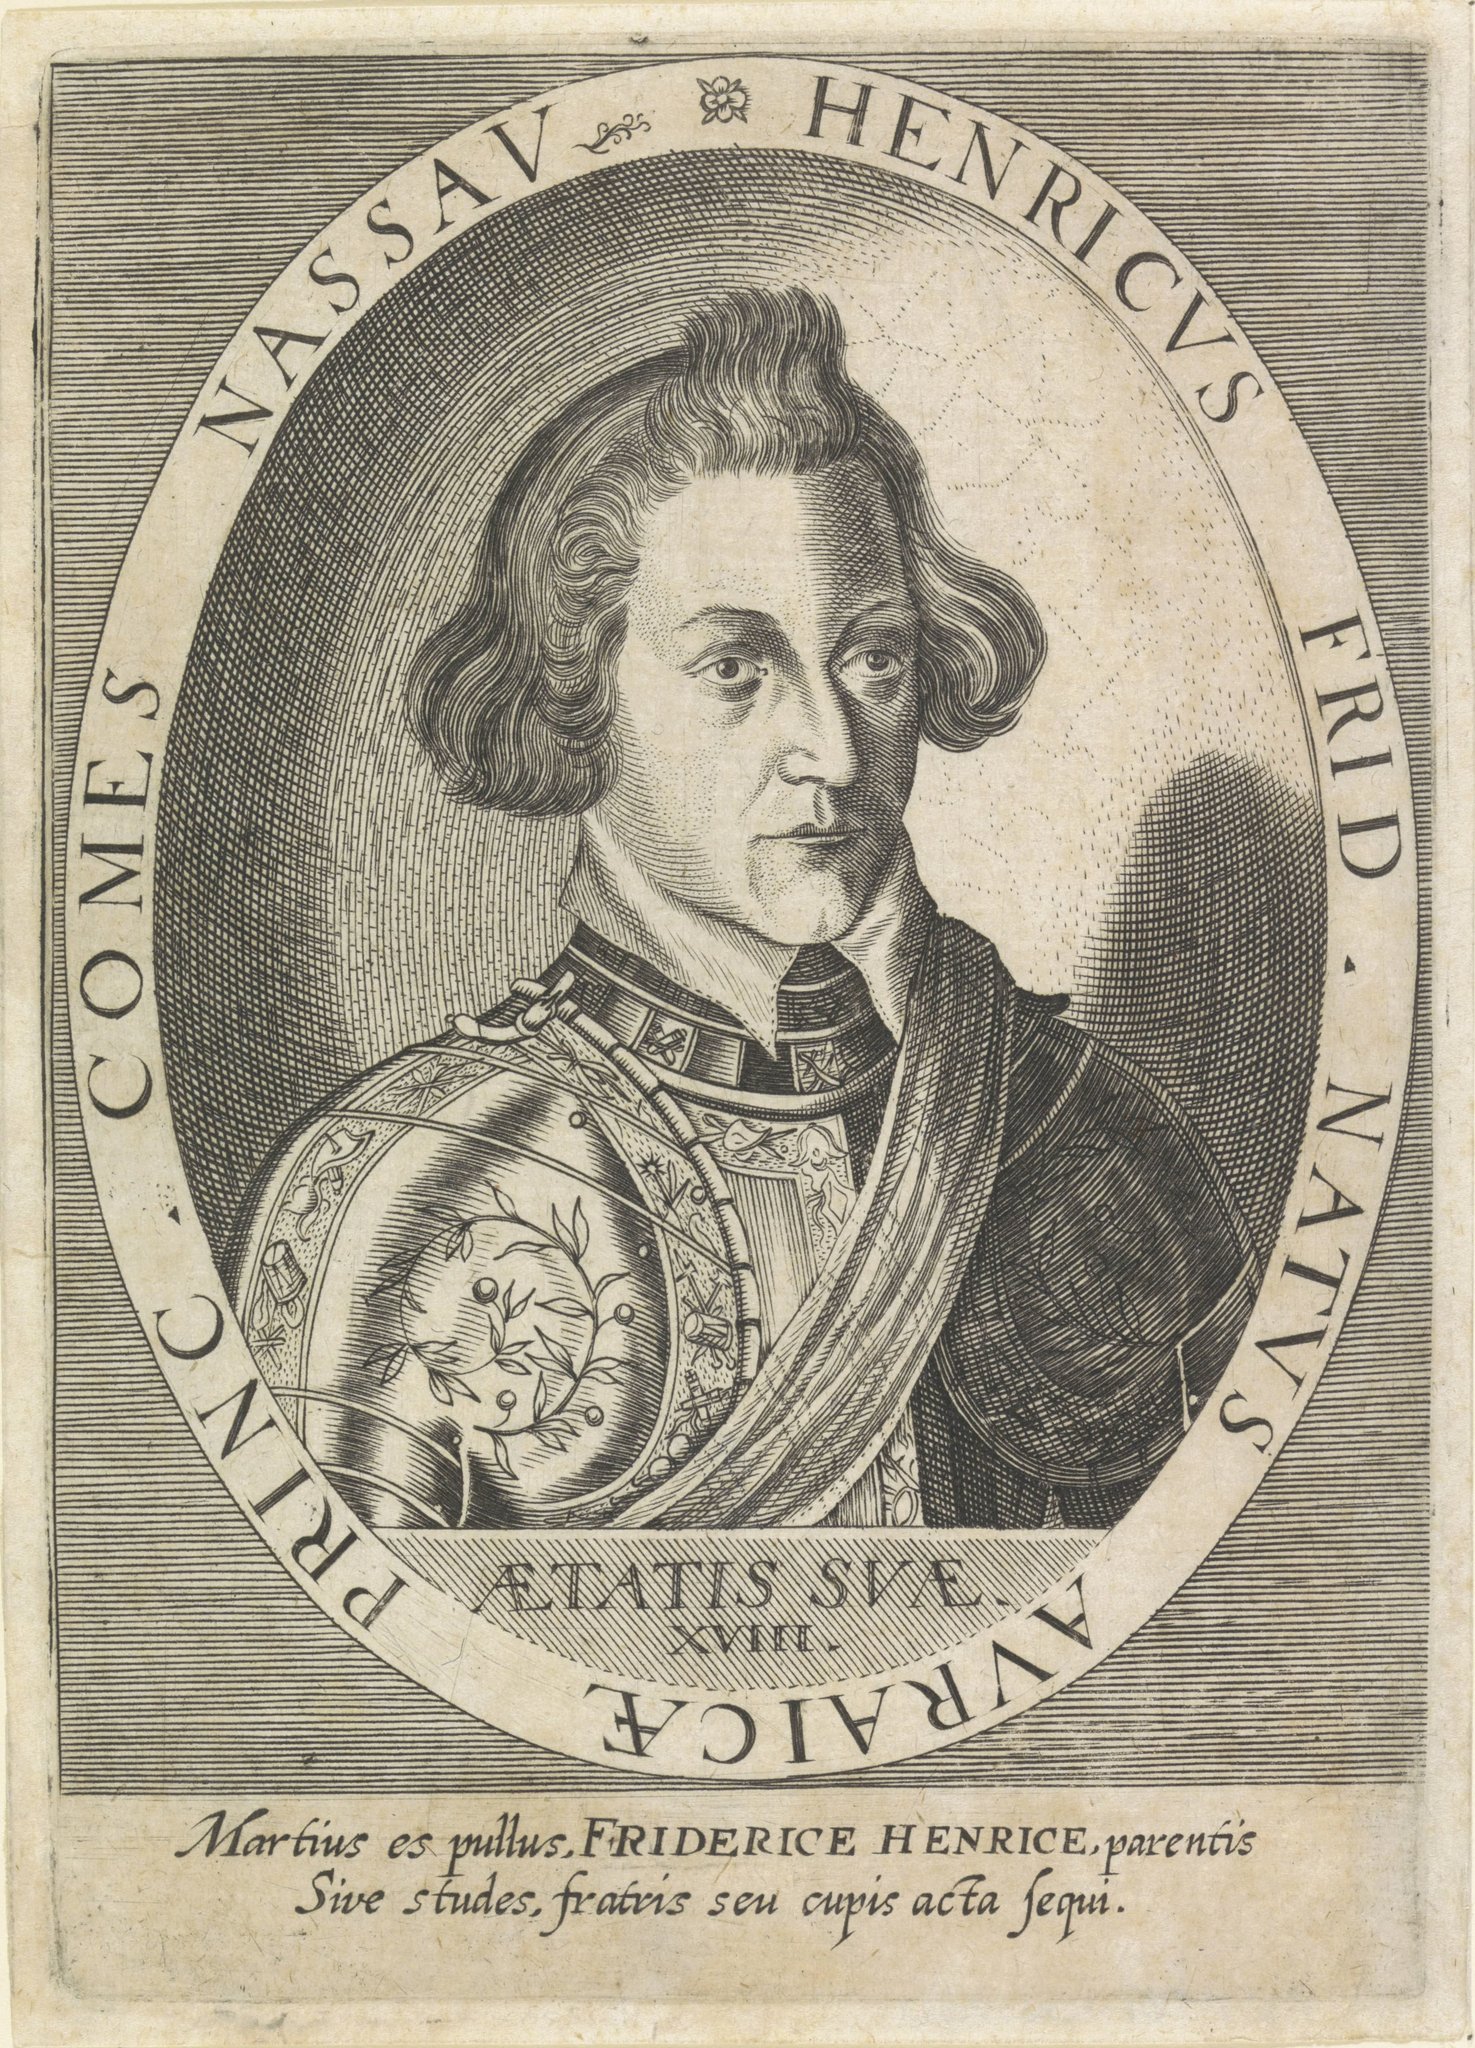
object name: print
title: Portret van Frederik Hendrik, prins van Oranje, op 18-jarige leeftijd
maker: Anonymous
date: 1600-1699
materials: paper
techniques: engraving, etching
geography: low countries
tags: the hague, frederick henry (prince of orange)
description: De hier vermelde titel verwijst naar de hoogst verkregen titel van de geportretteerde, niet per se naar de titel die de geportretteerde op deze voorstelling draagt.